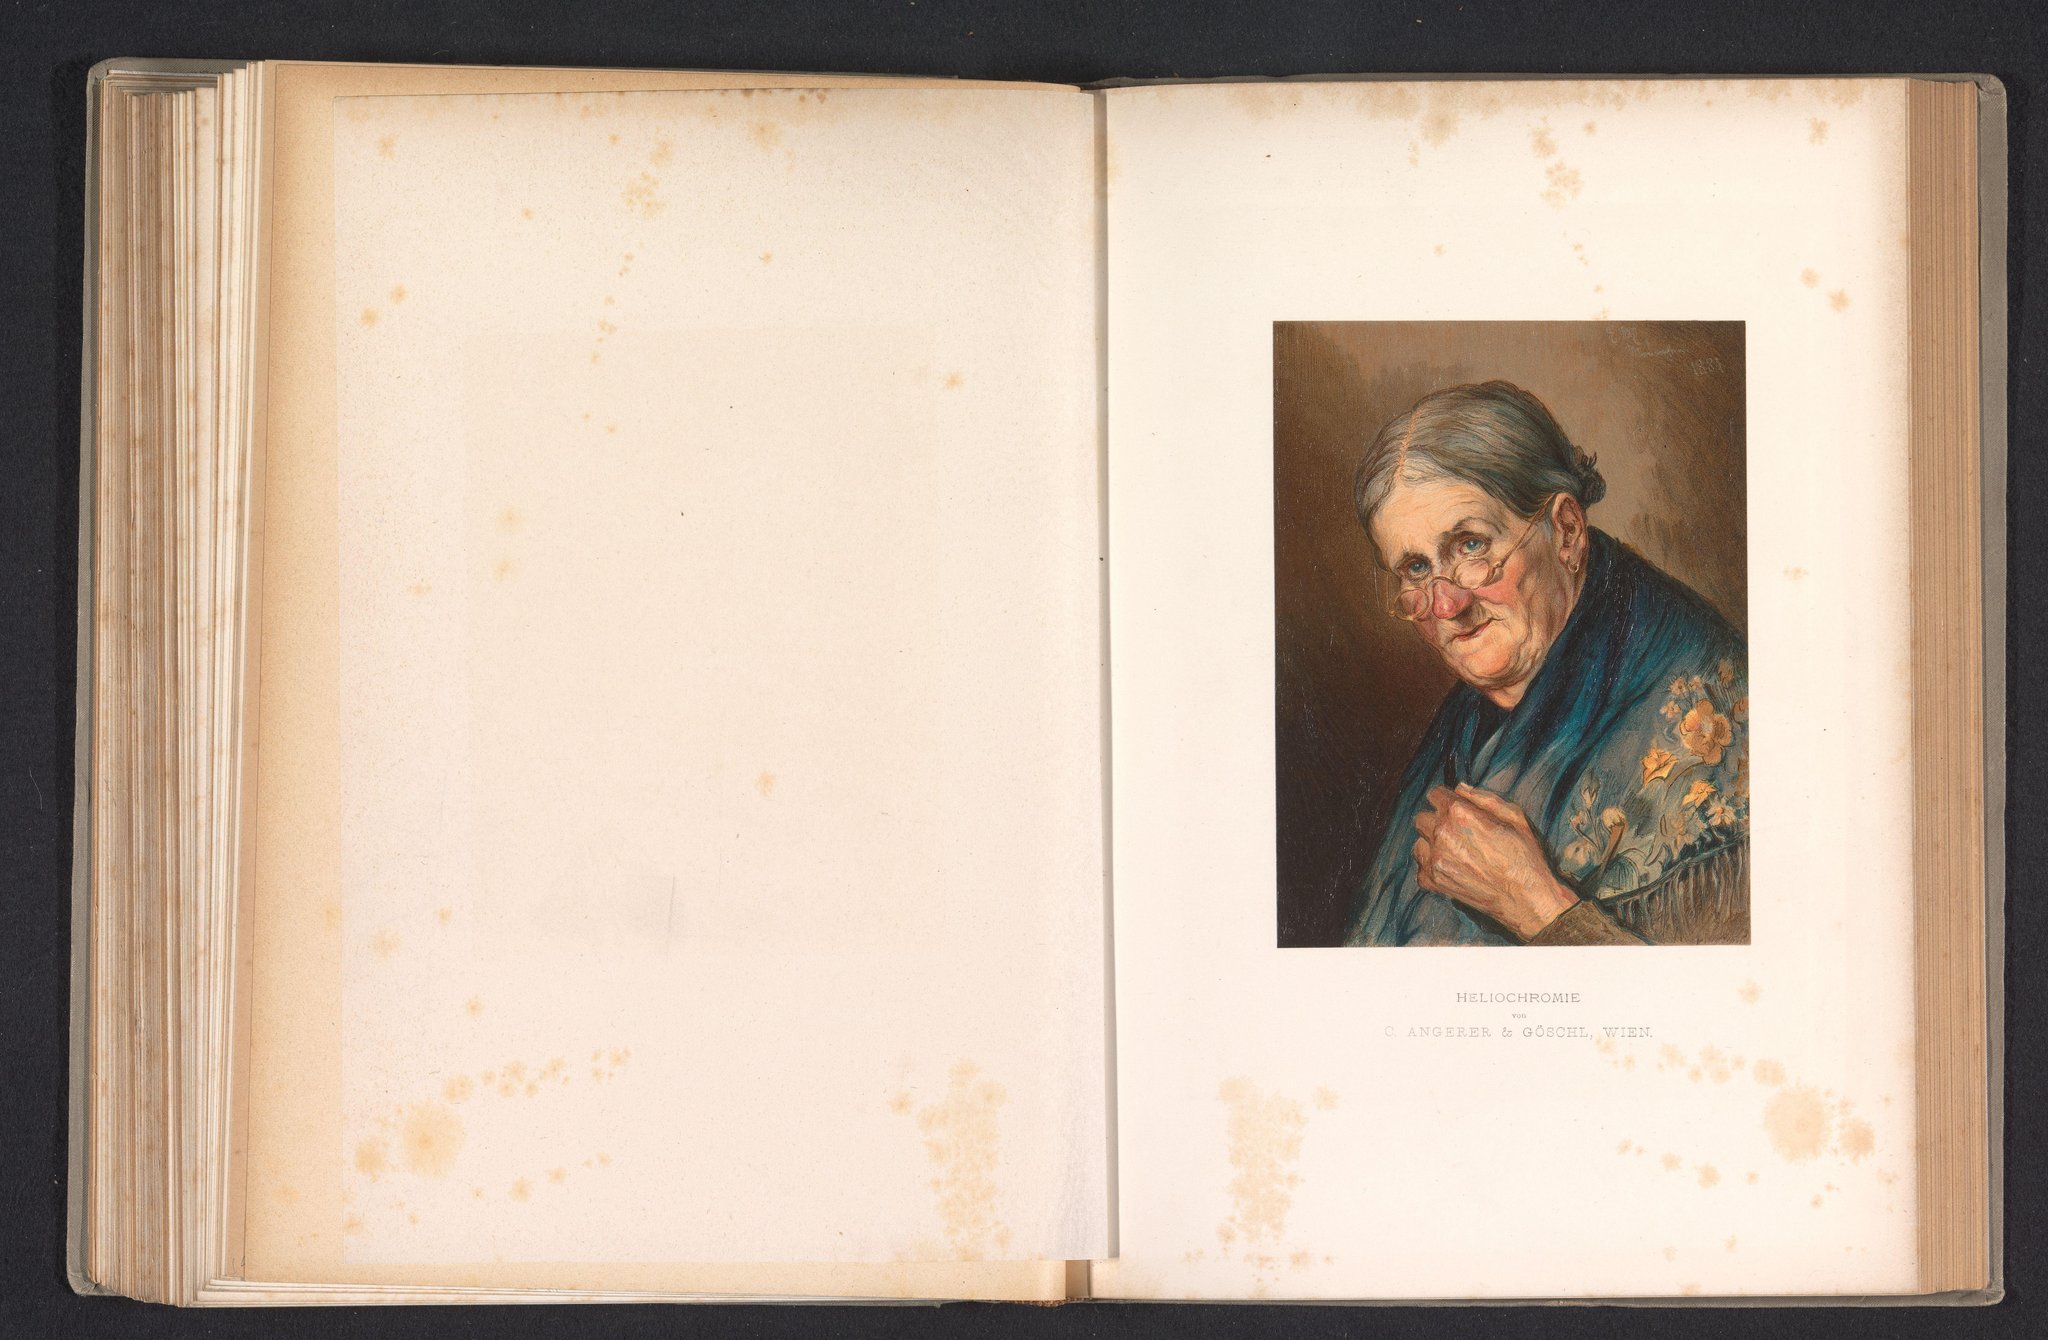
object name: page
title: Fotoreproductie van een schilderij, voorstellende een portret van een oude vrouw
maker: Anonymous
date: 1881-1883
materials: paper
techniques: oleograph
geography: vienna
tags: old woman